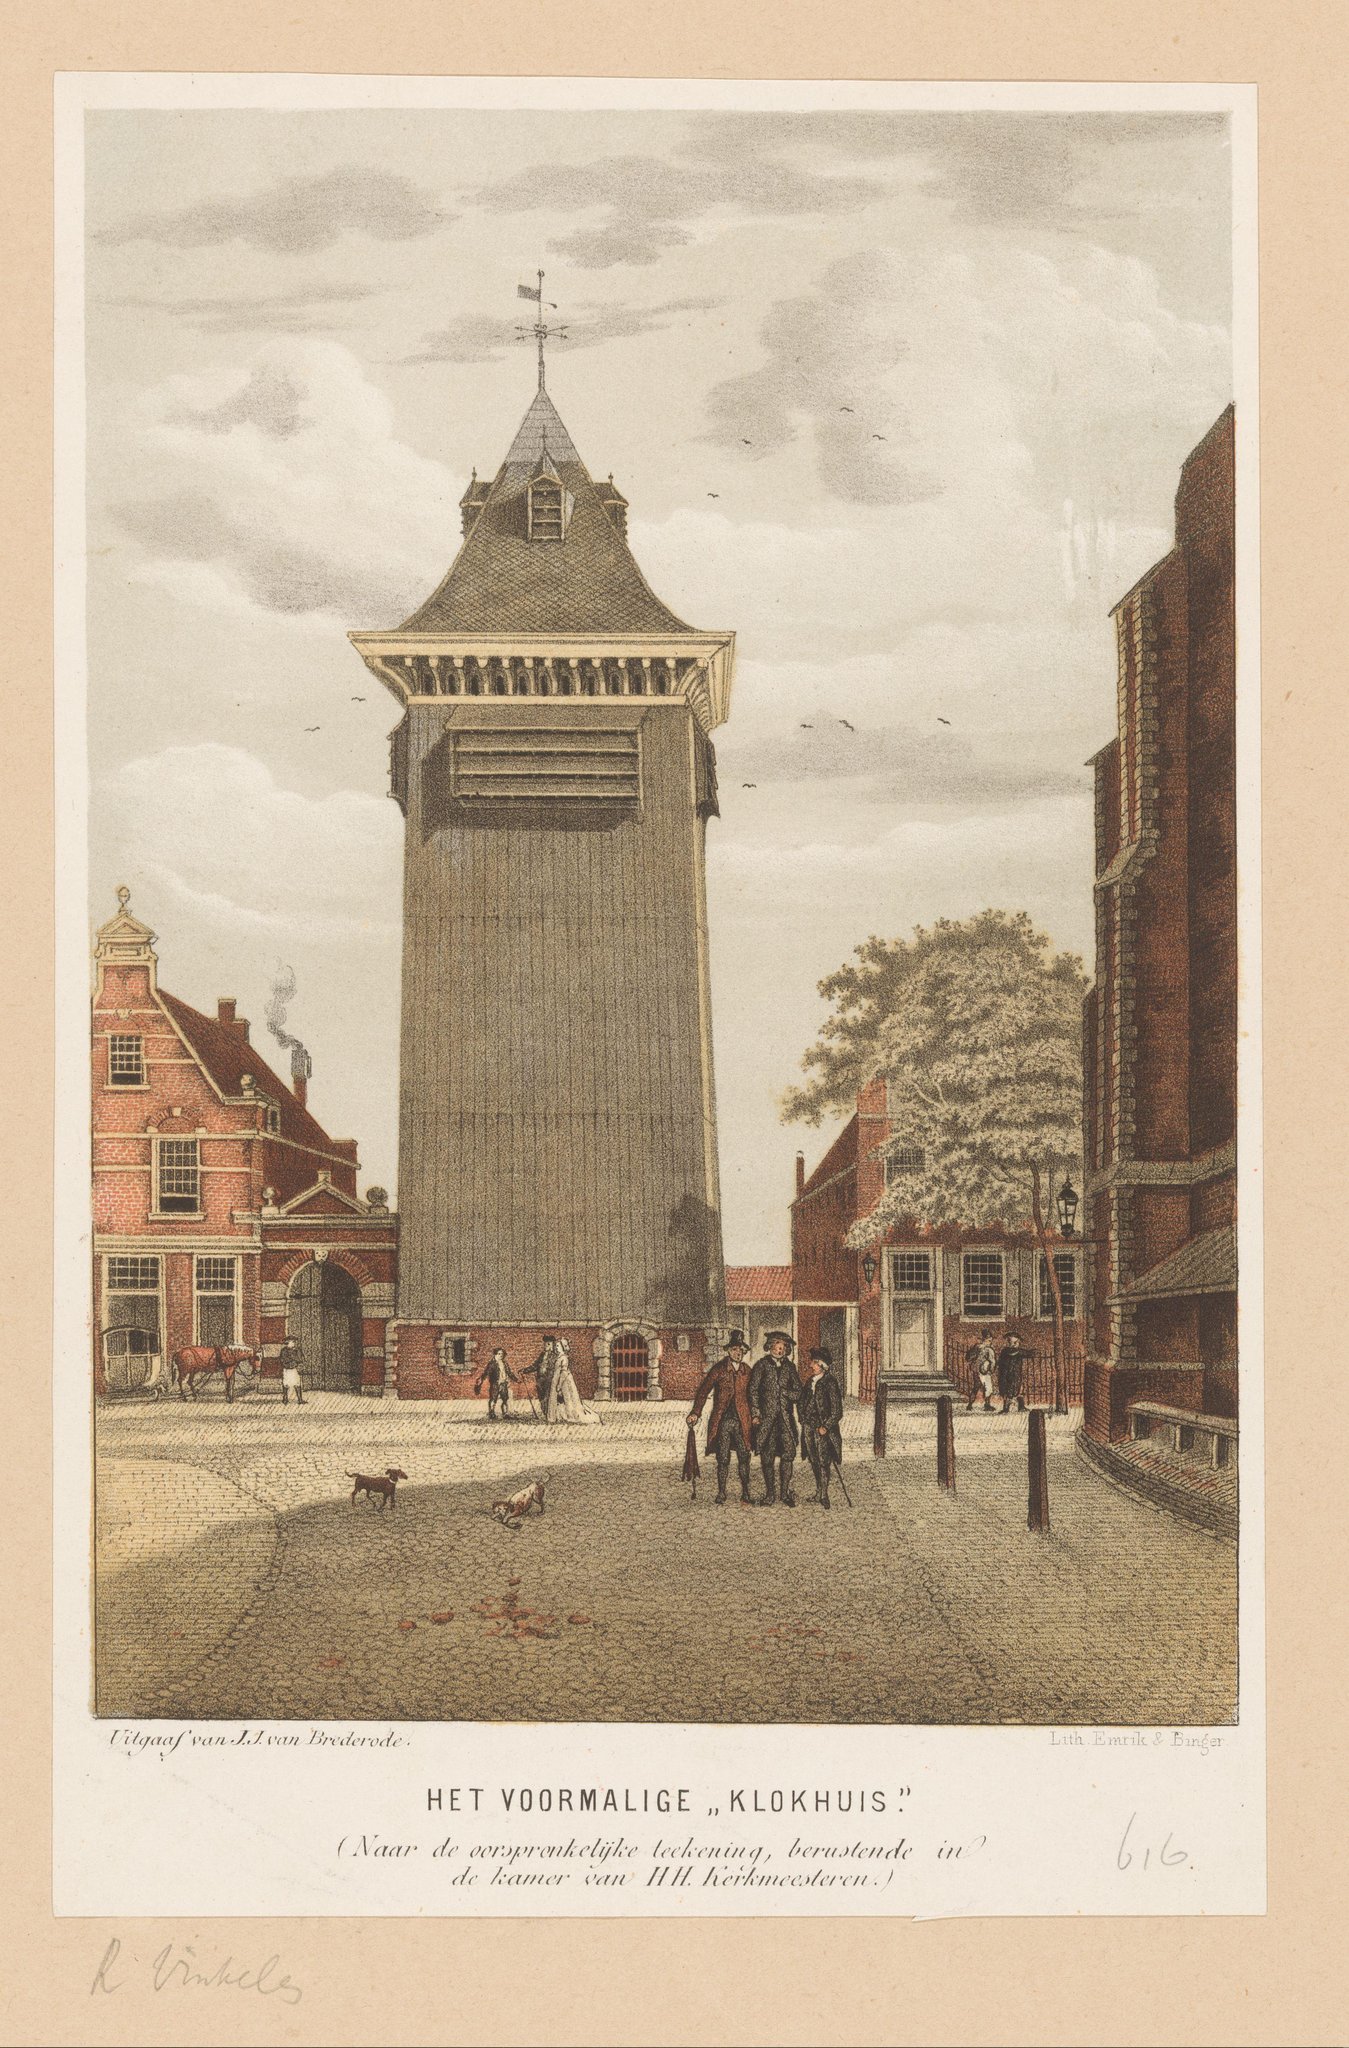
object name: print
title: Het voormalige "Klokhuis"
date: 1850-1900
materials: paper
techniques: lithograph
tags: tower, clock tower ~ monumental adornment, haarlem